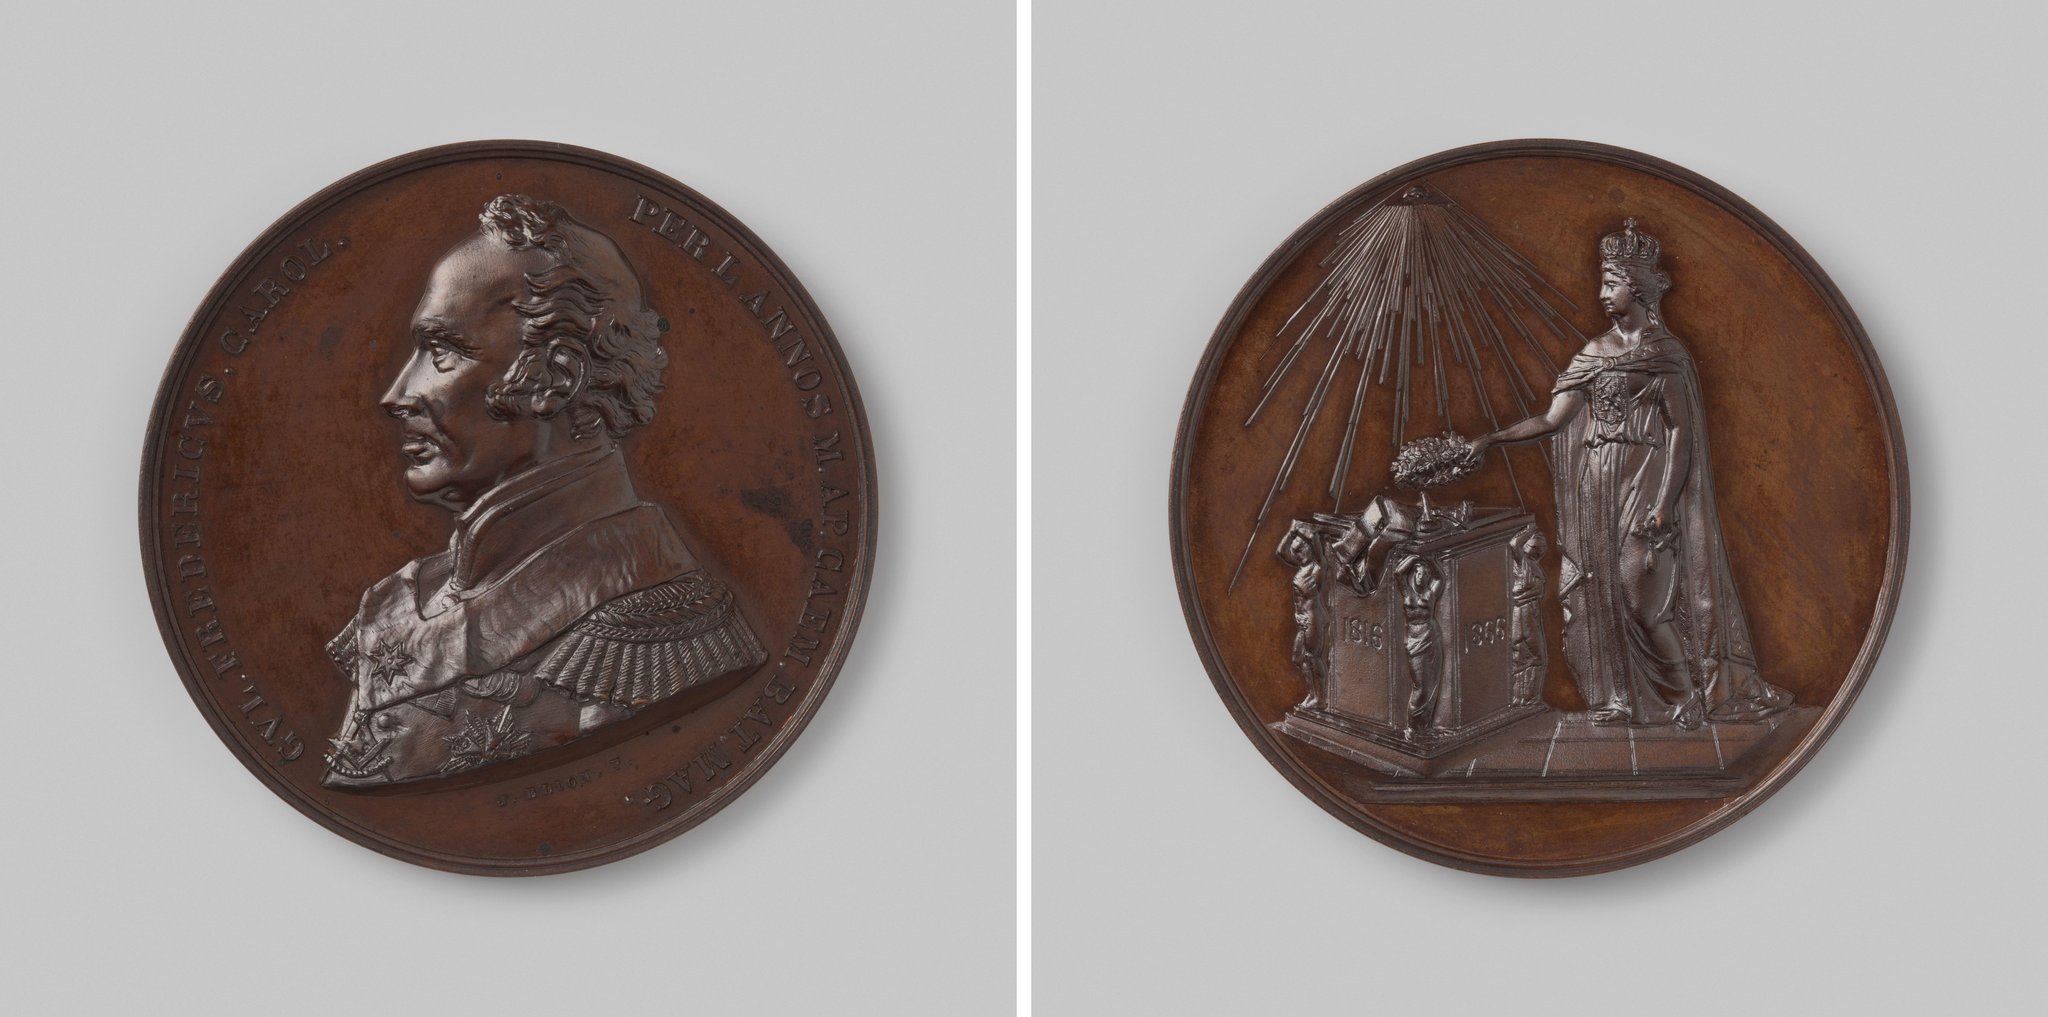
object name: history medal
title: Prins Frederik vijftig jaar Grootmeester van de Orde der Vrijmetselaars in Nederland 1866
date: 1866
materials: bronze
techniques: striking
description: Bronzen penning, op de voorzijde het borstbeeld van Frederik naar links met maçonniek draagteken, met omschrift, op de keerzijde de Nederlandse Maagd met maçonnieke attributen die, onder het stralend oog Gods, een draagteken op een versierd altaar lauwert.